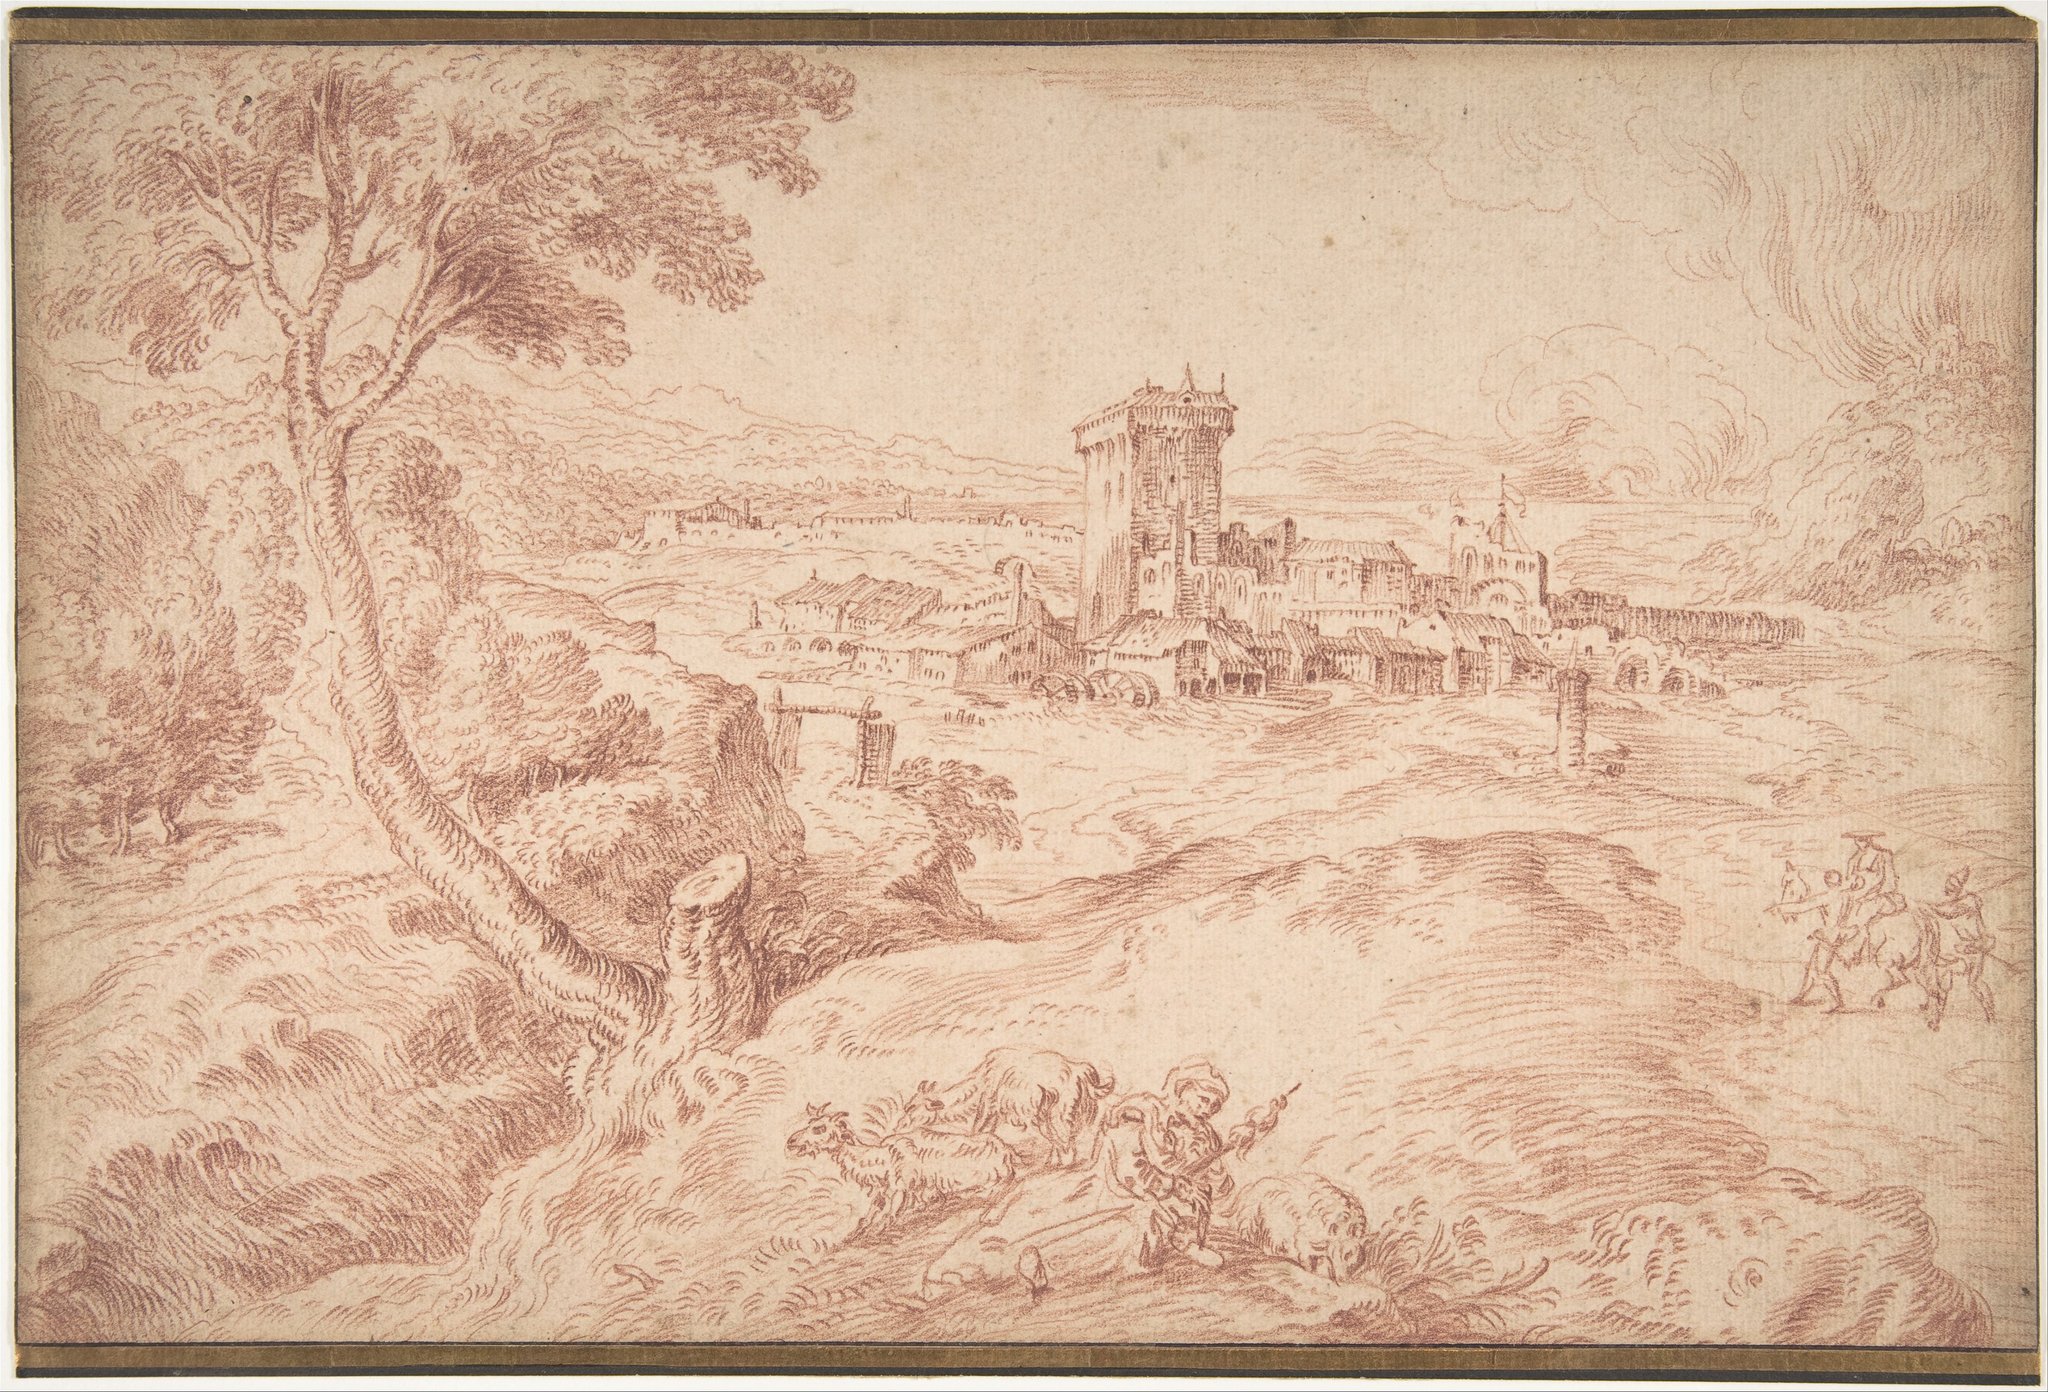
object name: drawing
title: Landscape with an Old Woman Holding a Spindle, after Domenico Campagnola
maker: antoine watteau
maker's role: artist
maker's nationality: french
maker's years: 1684-1721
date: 1715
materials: chalk, ink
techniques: pen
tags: towns,women,landscapes